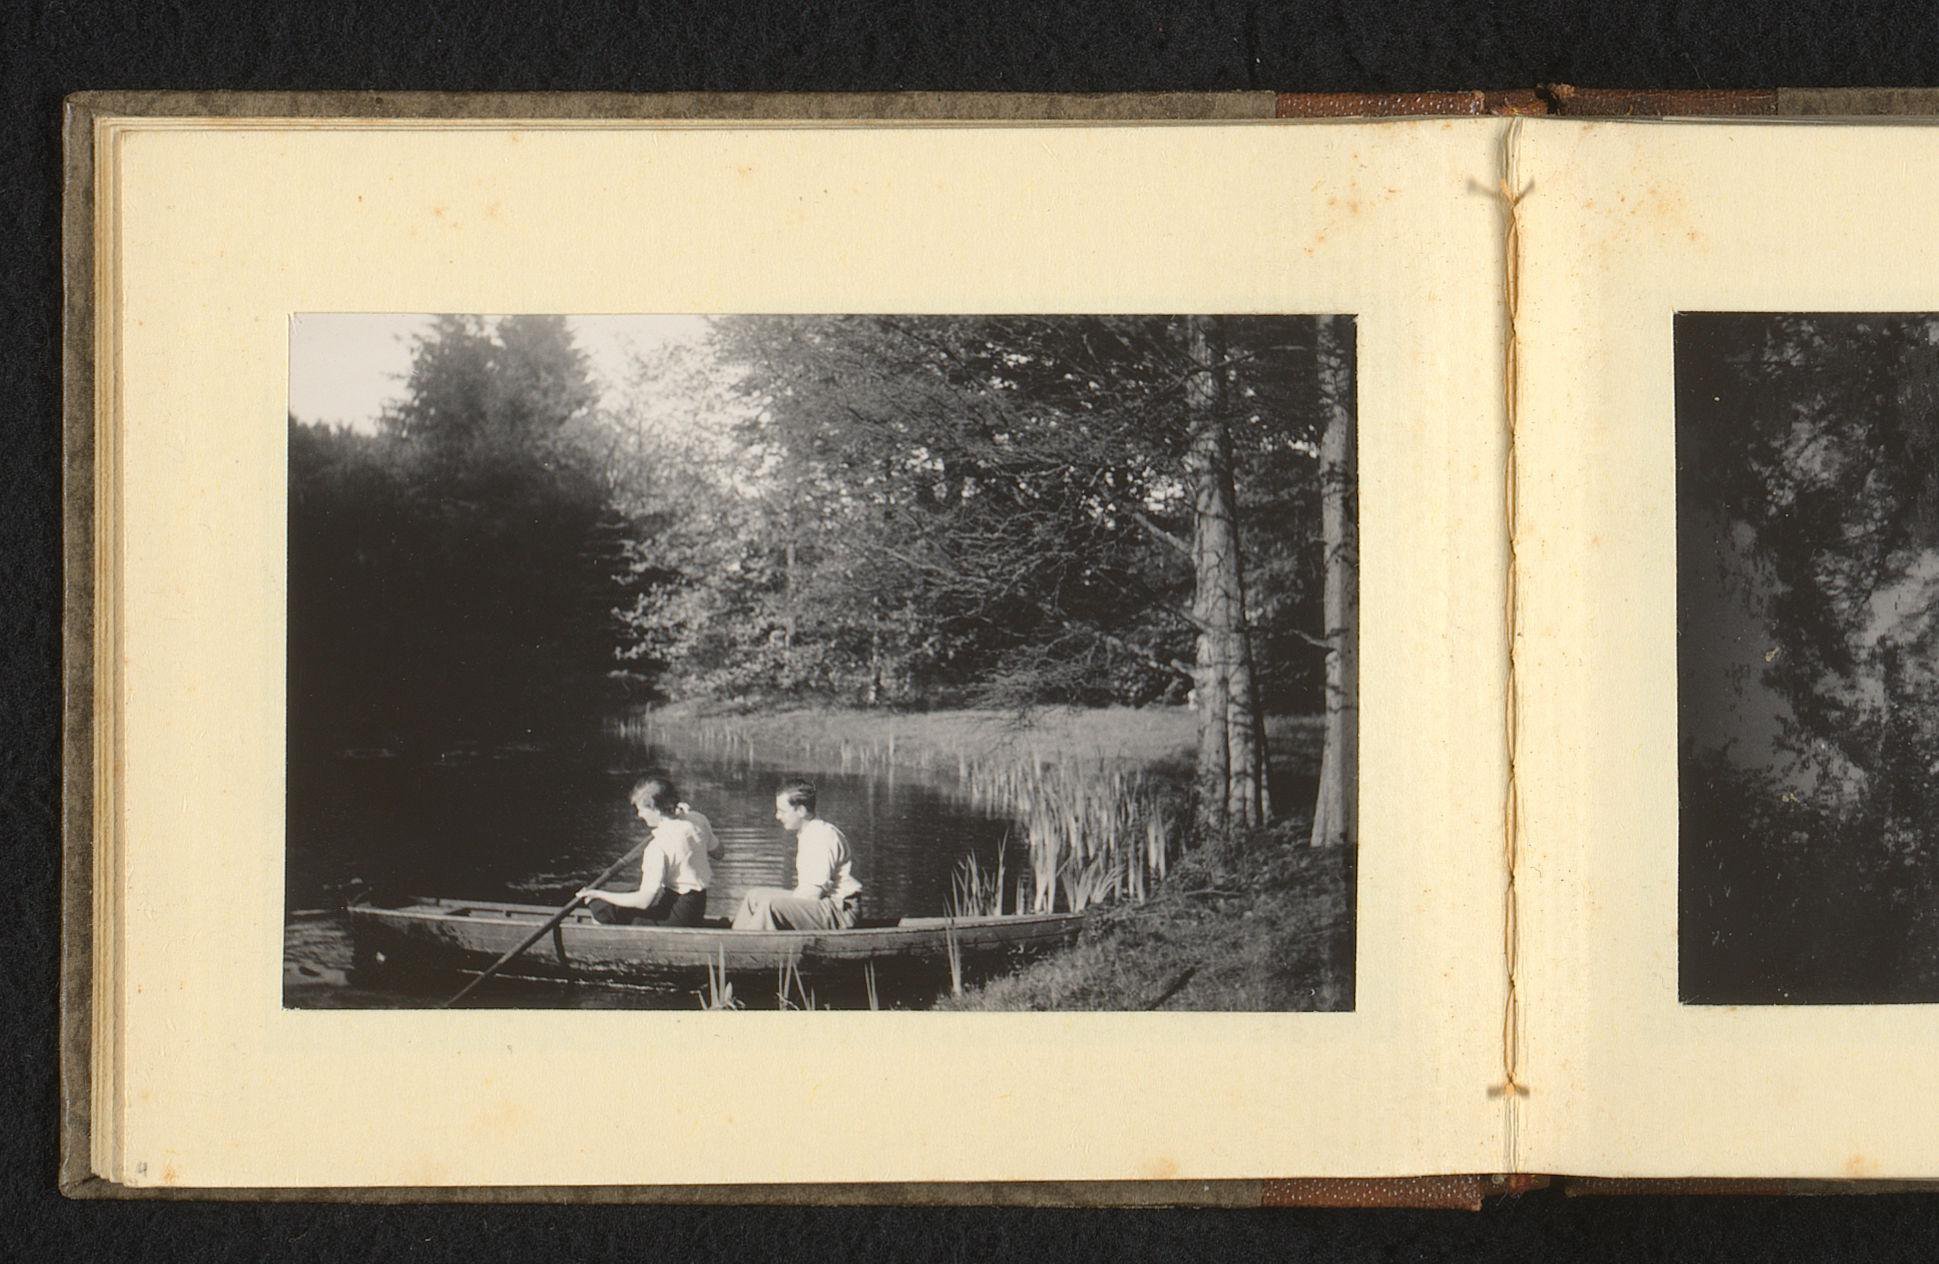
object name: photograph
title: Vrouw en man in een roeiboot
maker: norbert van den berg (1901-1972)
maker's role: amateurfotograaf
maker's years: 1901-1972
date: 1935-1950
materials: paper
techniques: gelatin silver print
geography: netherlands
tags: adult woman, adult man, rowing-boat, canoe, etc.